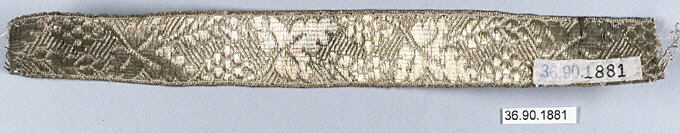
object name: galloon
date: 1767-1833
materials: metal thread, silk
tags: leaves